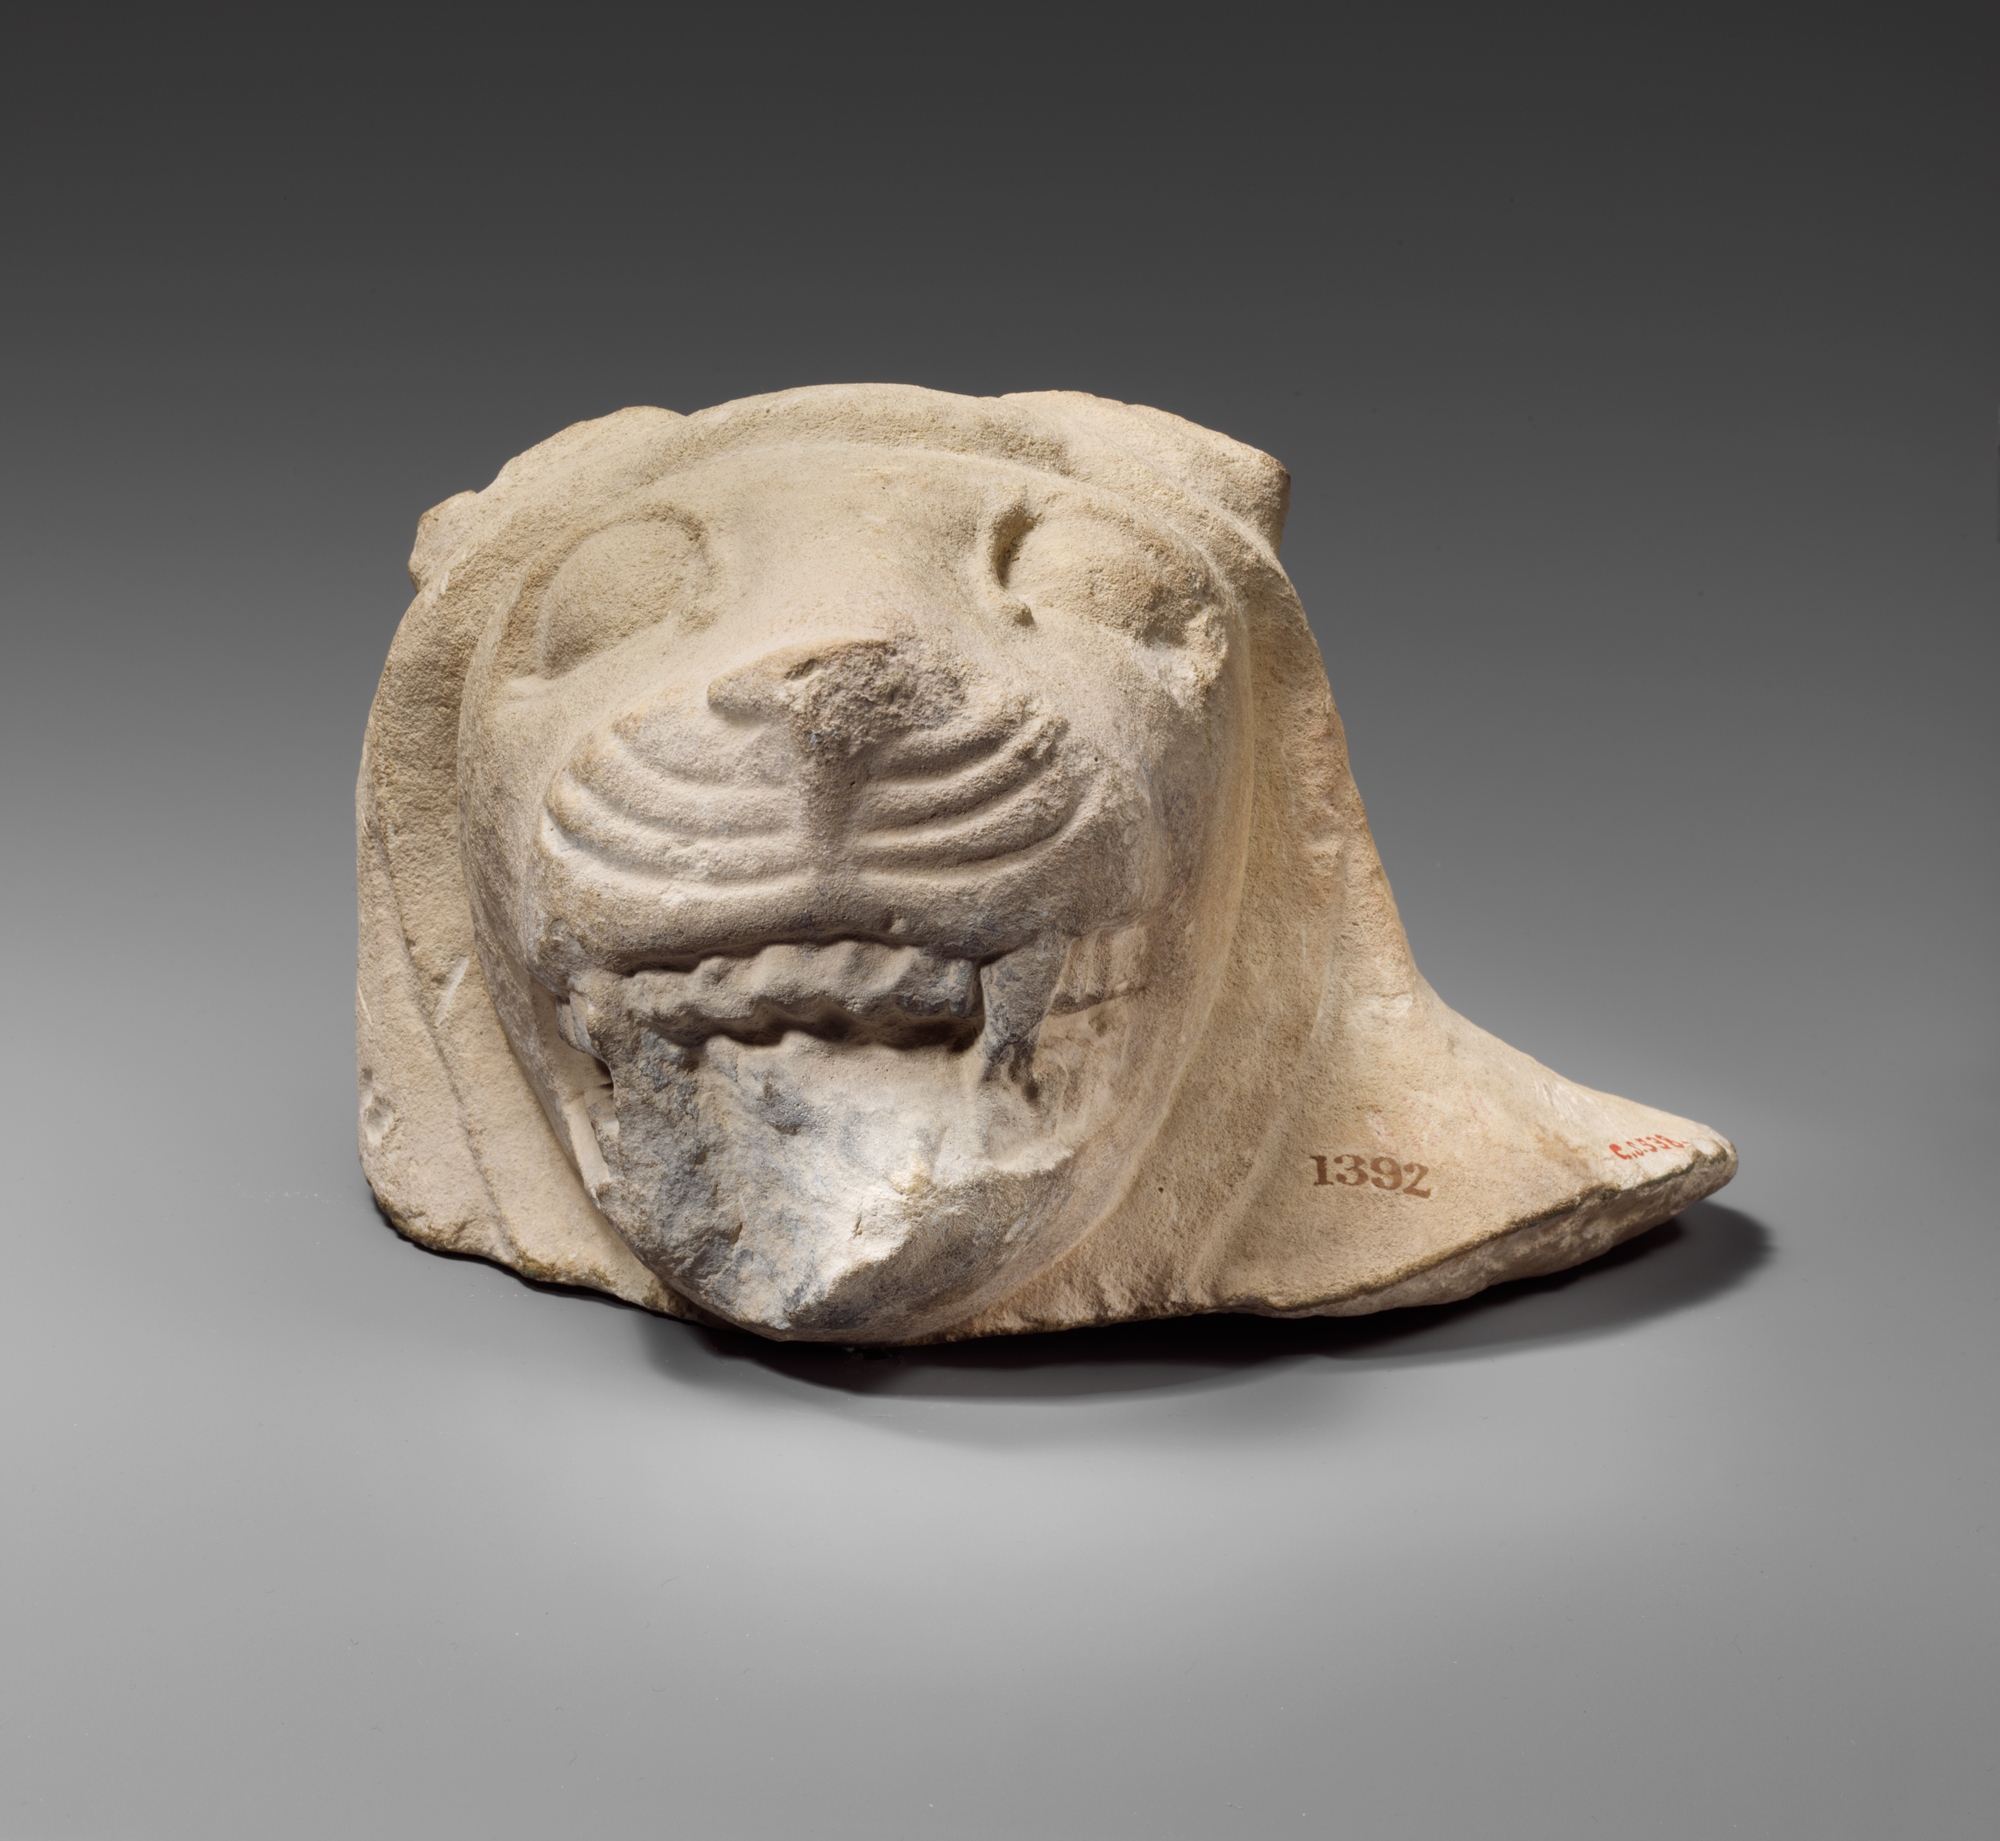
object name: head of a lion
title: Limestone head of a lion from a votive stele (?)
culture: cypriot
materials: limestone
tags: lions